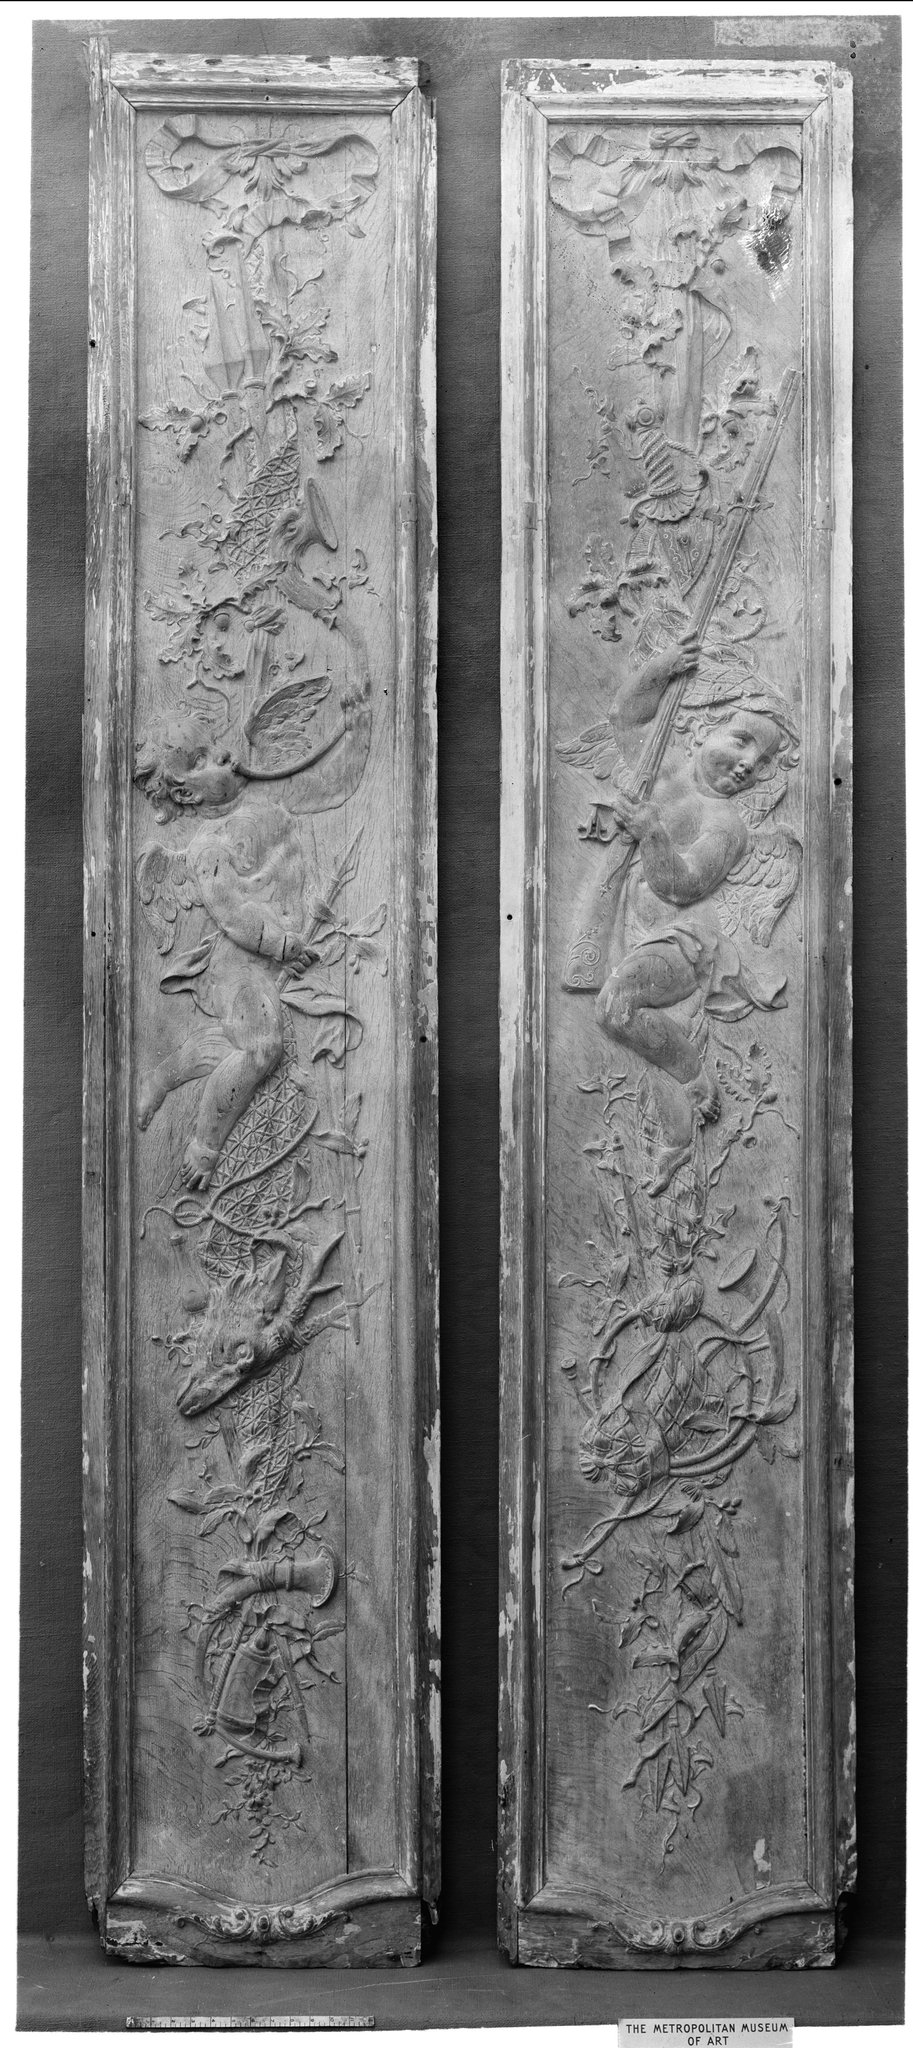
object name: panel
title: Pair of panels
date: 1701-1800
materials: wood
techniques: carving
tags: musical instruments,firearms,putti